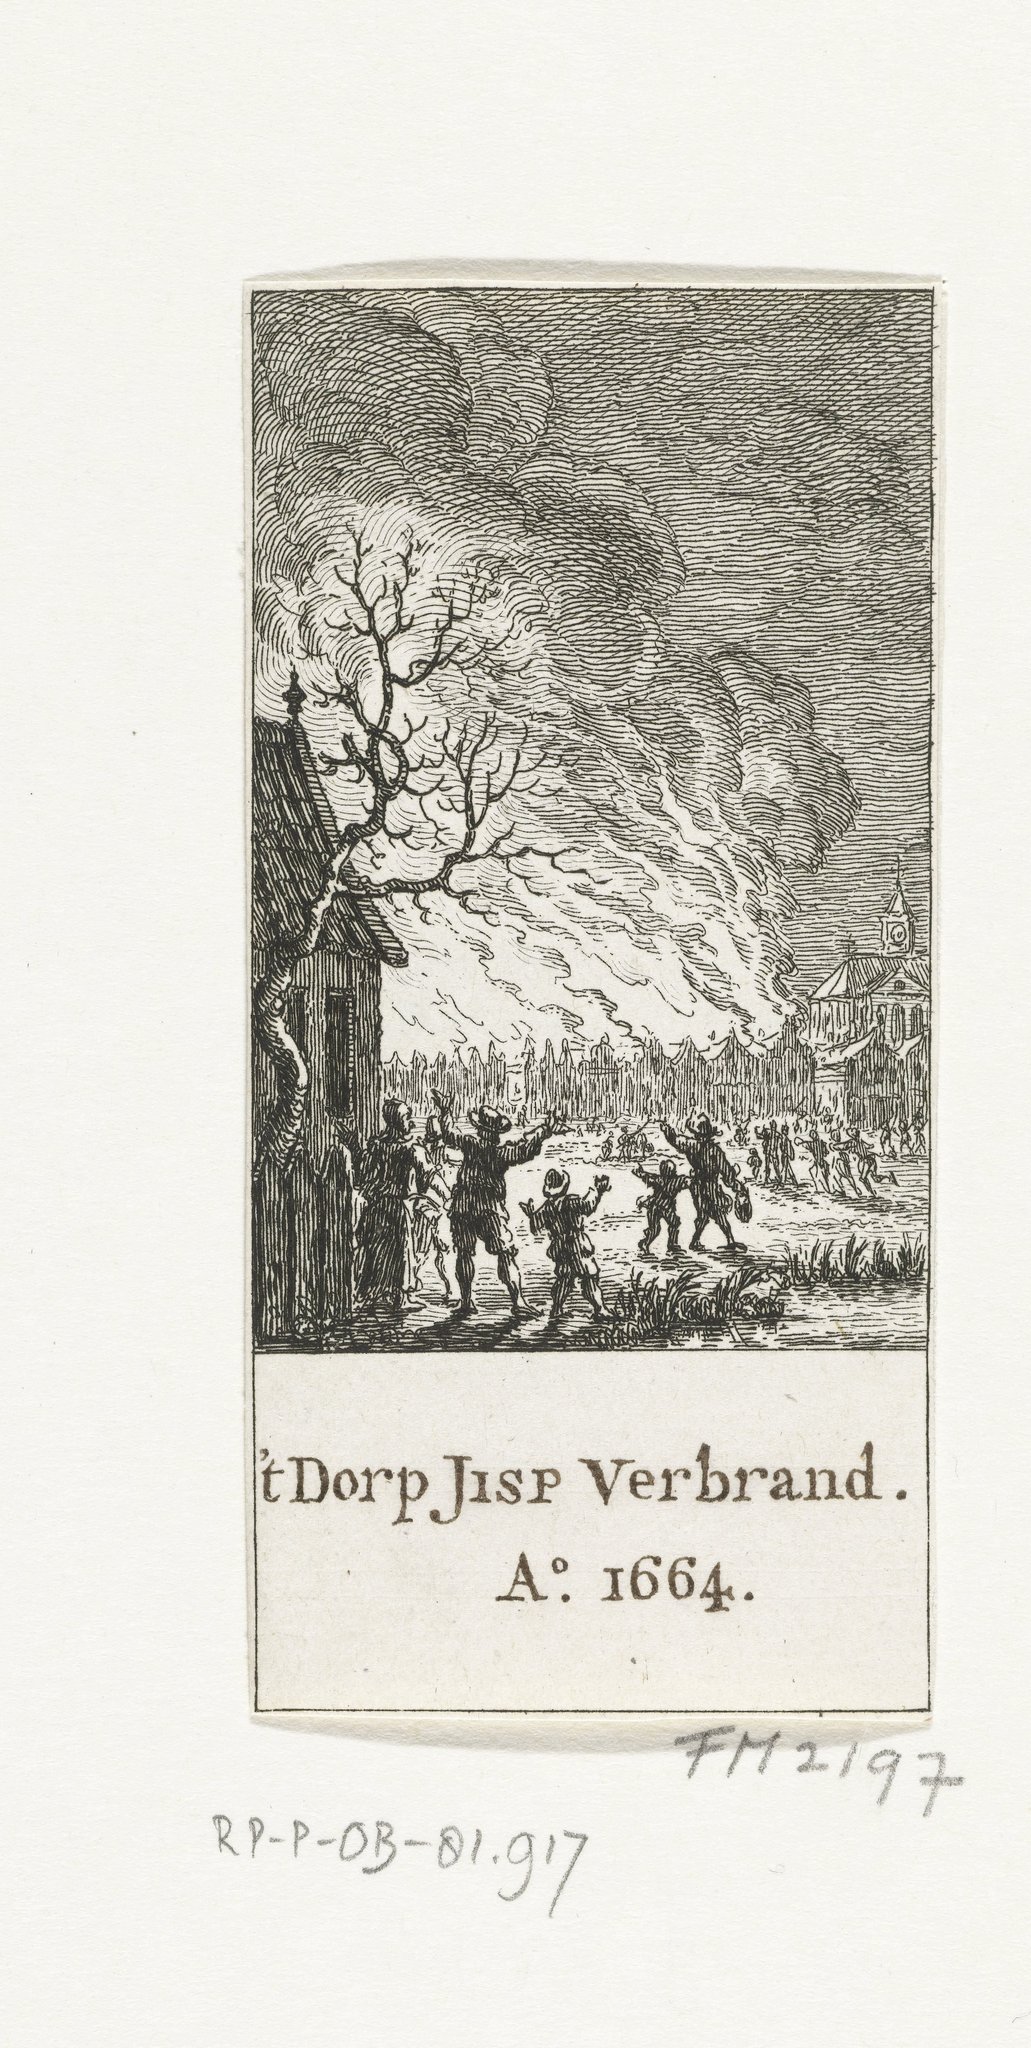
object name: history print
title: Brand te Jisp, 1664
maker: simon fokke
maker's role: draughtsman, print maker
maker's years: 1712-1784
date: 1773-1774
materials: paper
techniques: etching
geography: northern netherlands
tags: on fire, ablaze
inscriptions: inscription: ‘'t Dorp Jisp Verbrand. Ao. 1664’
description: Gebruikt als illustratie in: Historische, Geographische, Konst- en - Reis Almanach voor den Jaare 1774, Amsterdam: Steven van Esveldt en Holtrop, nr. 86.